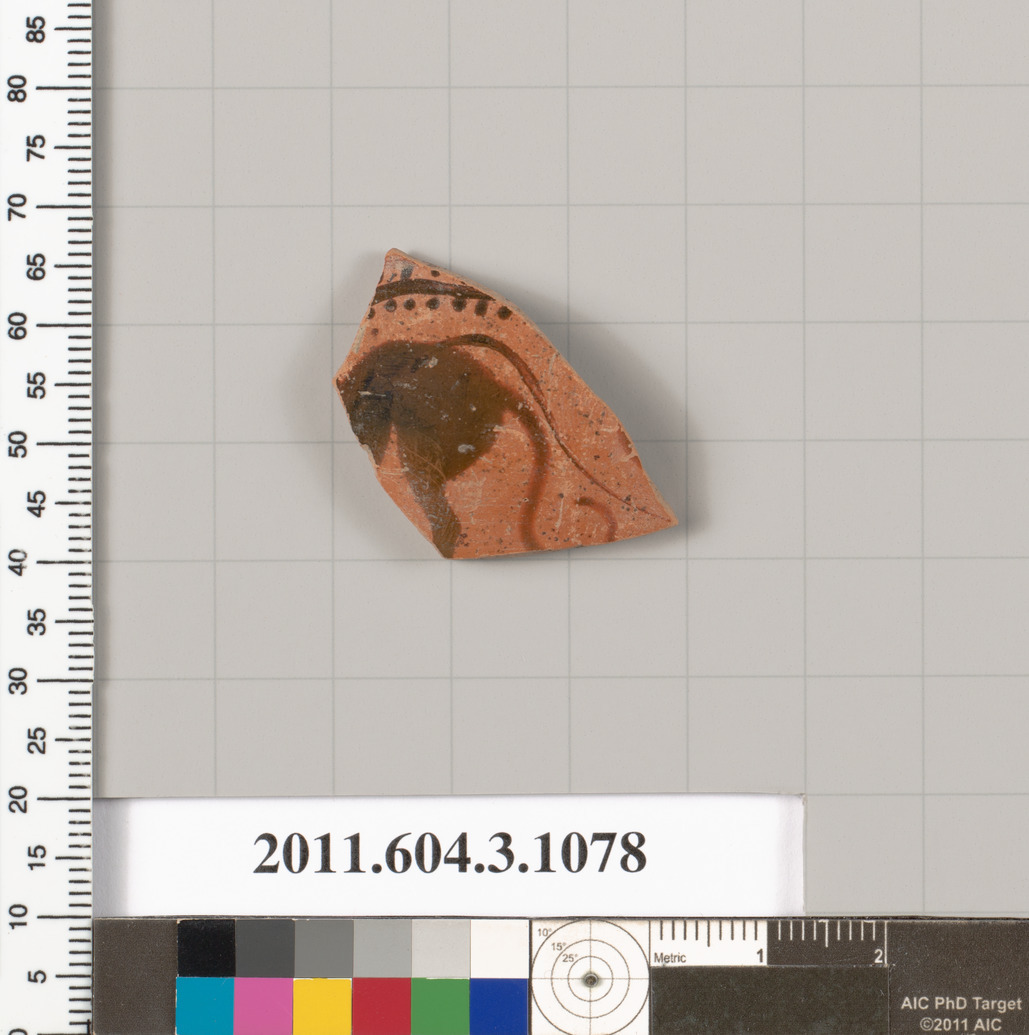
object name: mastoid fragment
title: Terracotta fragment of a mastoid (drinking cup with narrow base)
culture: greek, attic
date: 534-468 BCE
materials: terracotta